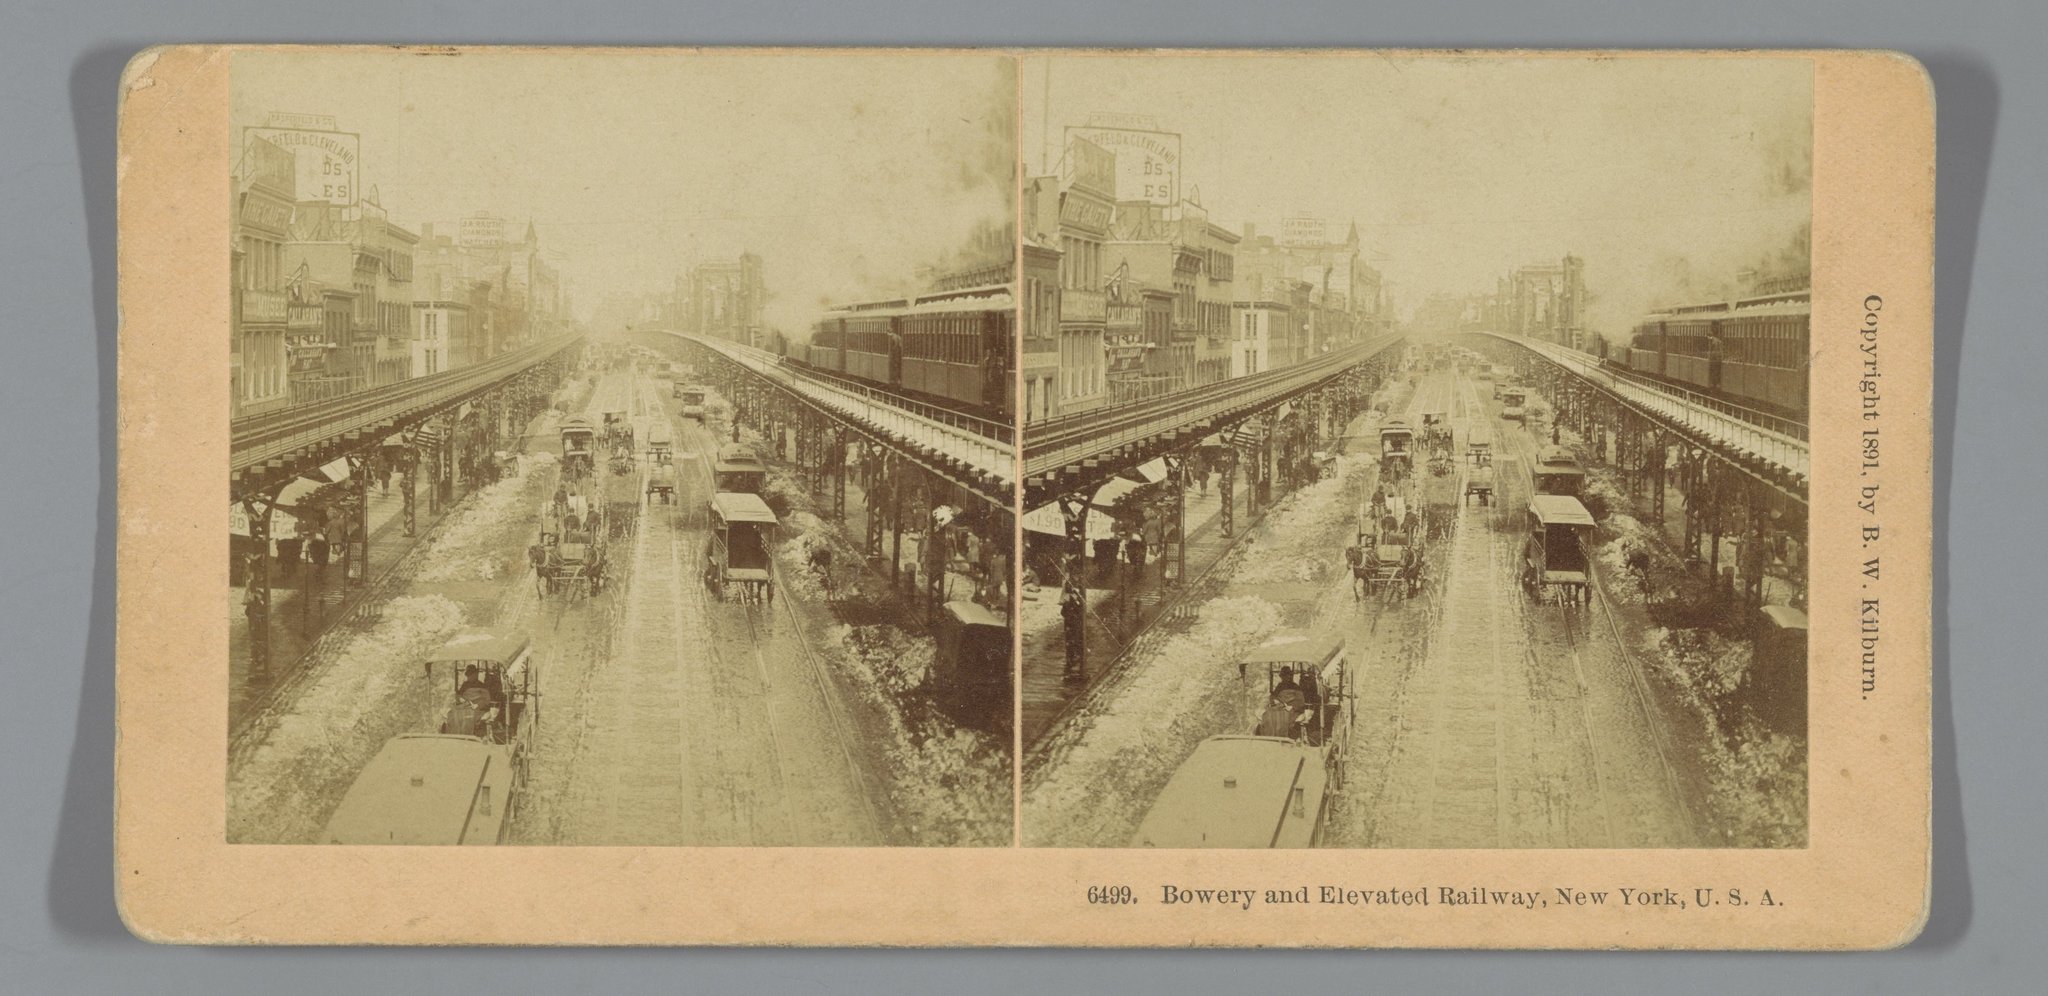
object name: stereograph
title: Bowery and Elevated Railway, New York, U.S.A.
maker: benjamin west kilburn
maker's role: fotograaf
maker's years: 1827-1909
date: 1891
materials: cardboard, paper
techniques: albumen print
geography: littleton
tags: railway, train, new york (city)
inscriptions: number: ‘6499’, copyright notice: ‘Copyright 1891, by B. W. Kilburn.’, number: ‘15’